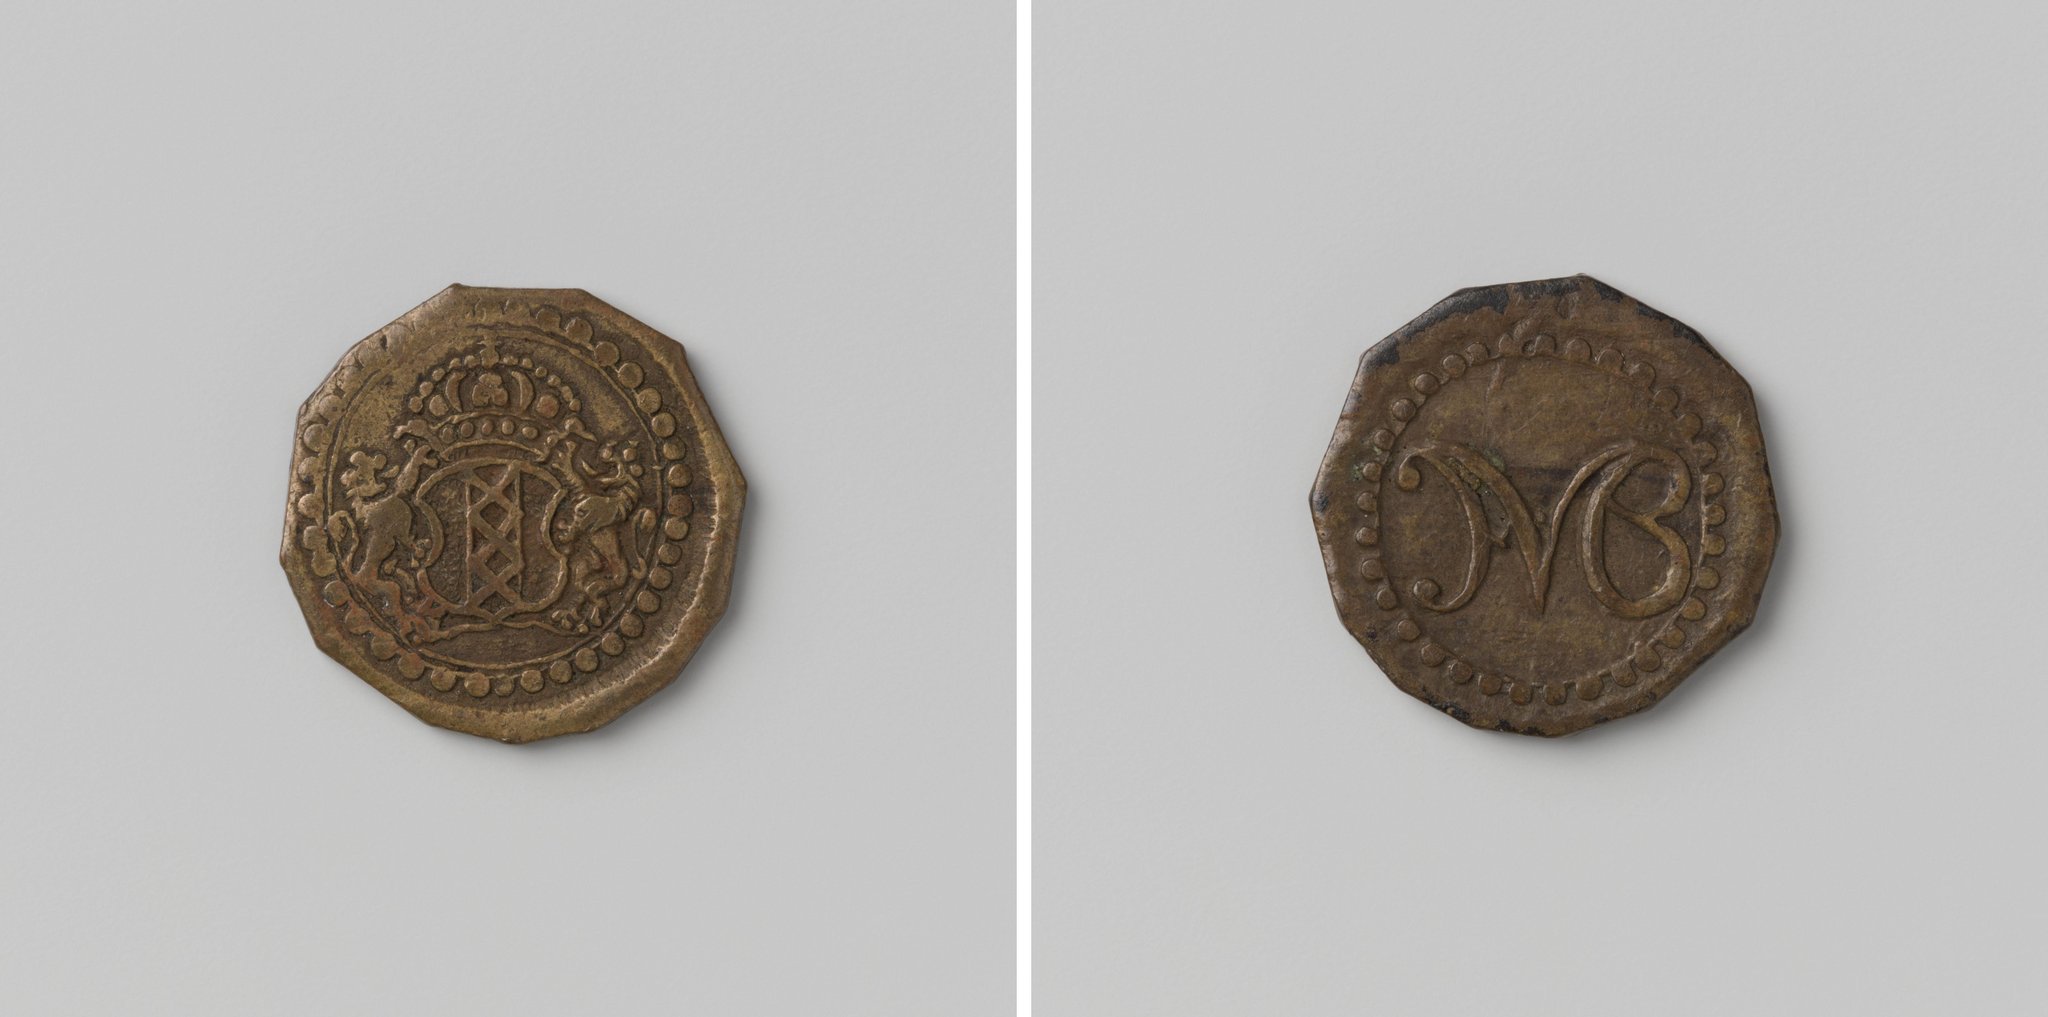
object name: medal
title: Makelaarsgilde van Amsterdam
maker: Anonymous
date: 1600-1800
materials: brass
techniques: striking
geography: amsterdam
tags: amsterdam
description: Messing veelhoekig armenloodje. Voorzijde: in ronde parelcirkel: gekroond wapenschild, geflankeerd door twee leeuwen. Keerzijde: in ronde parelcirkel: monogram van letters M, A, R en S.